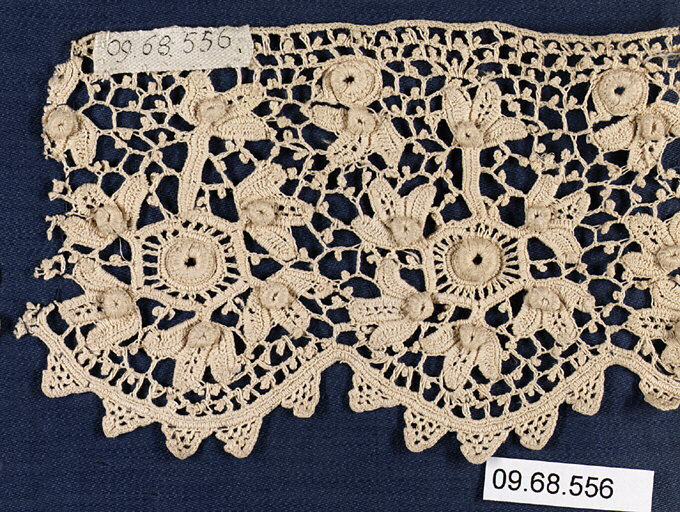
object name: specimen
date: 1801-1900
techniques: crochet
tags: flowers